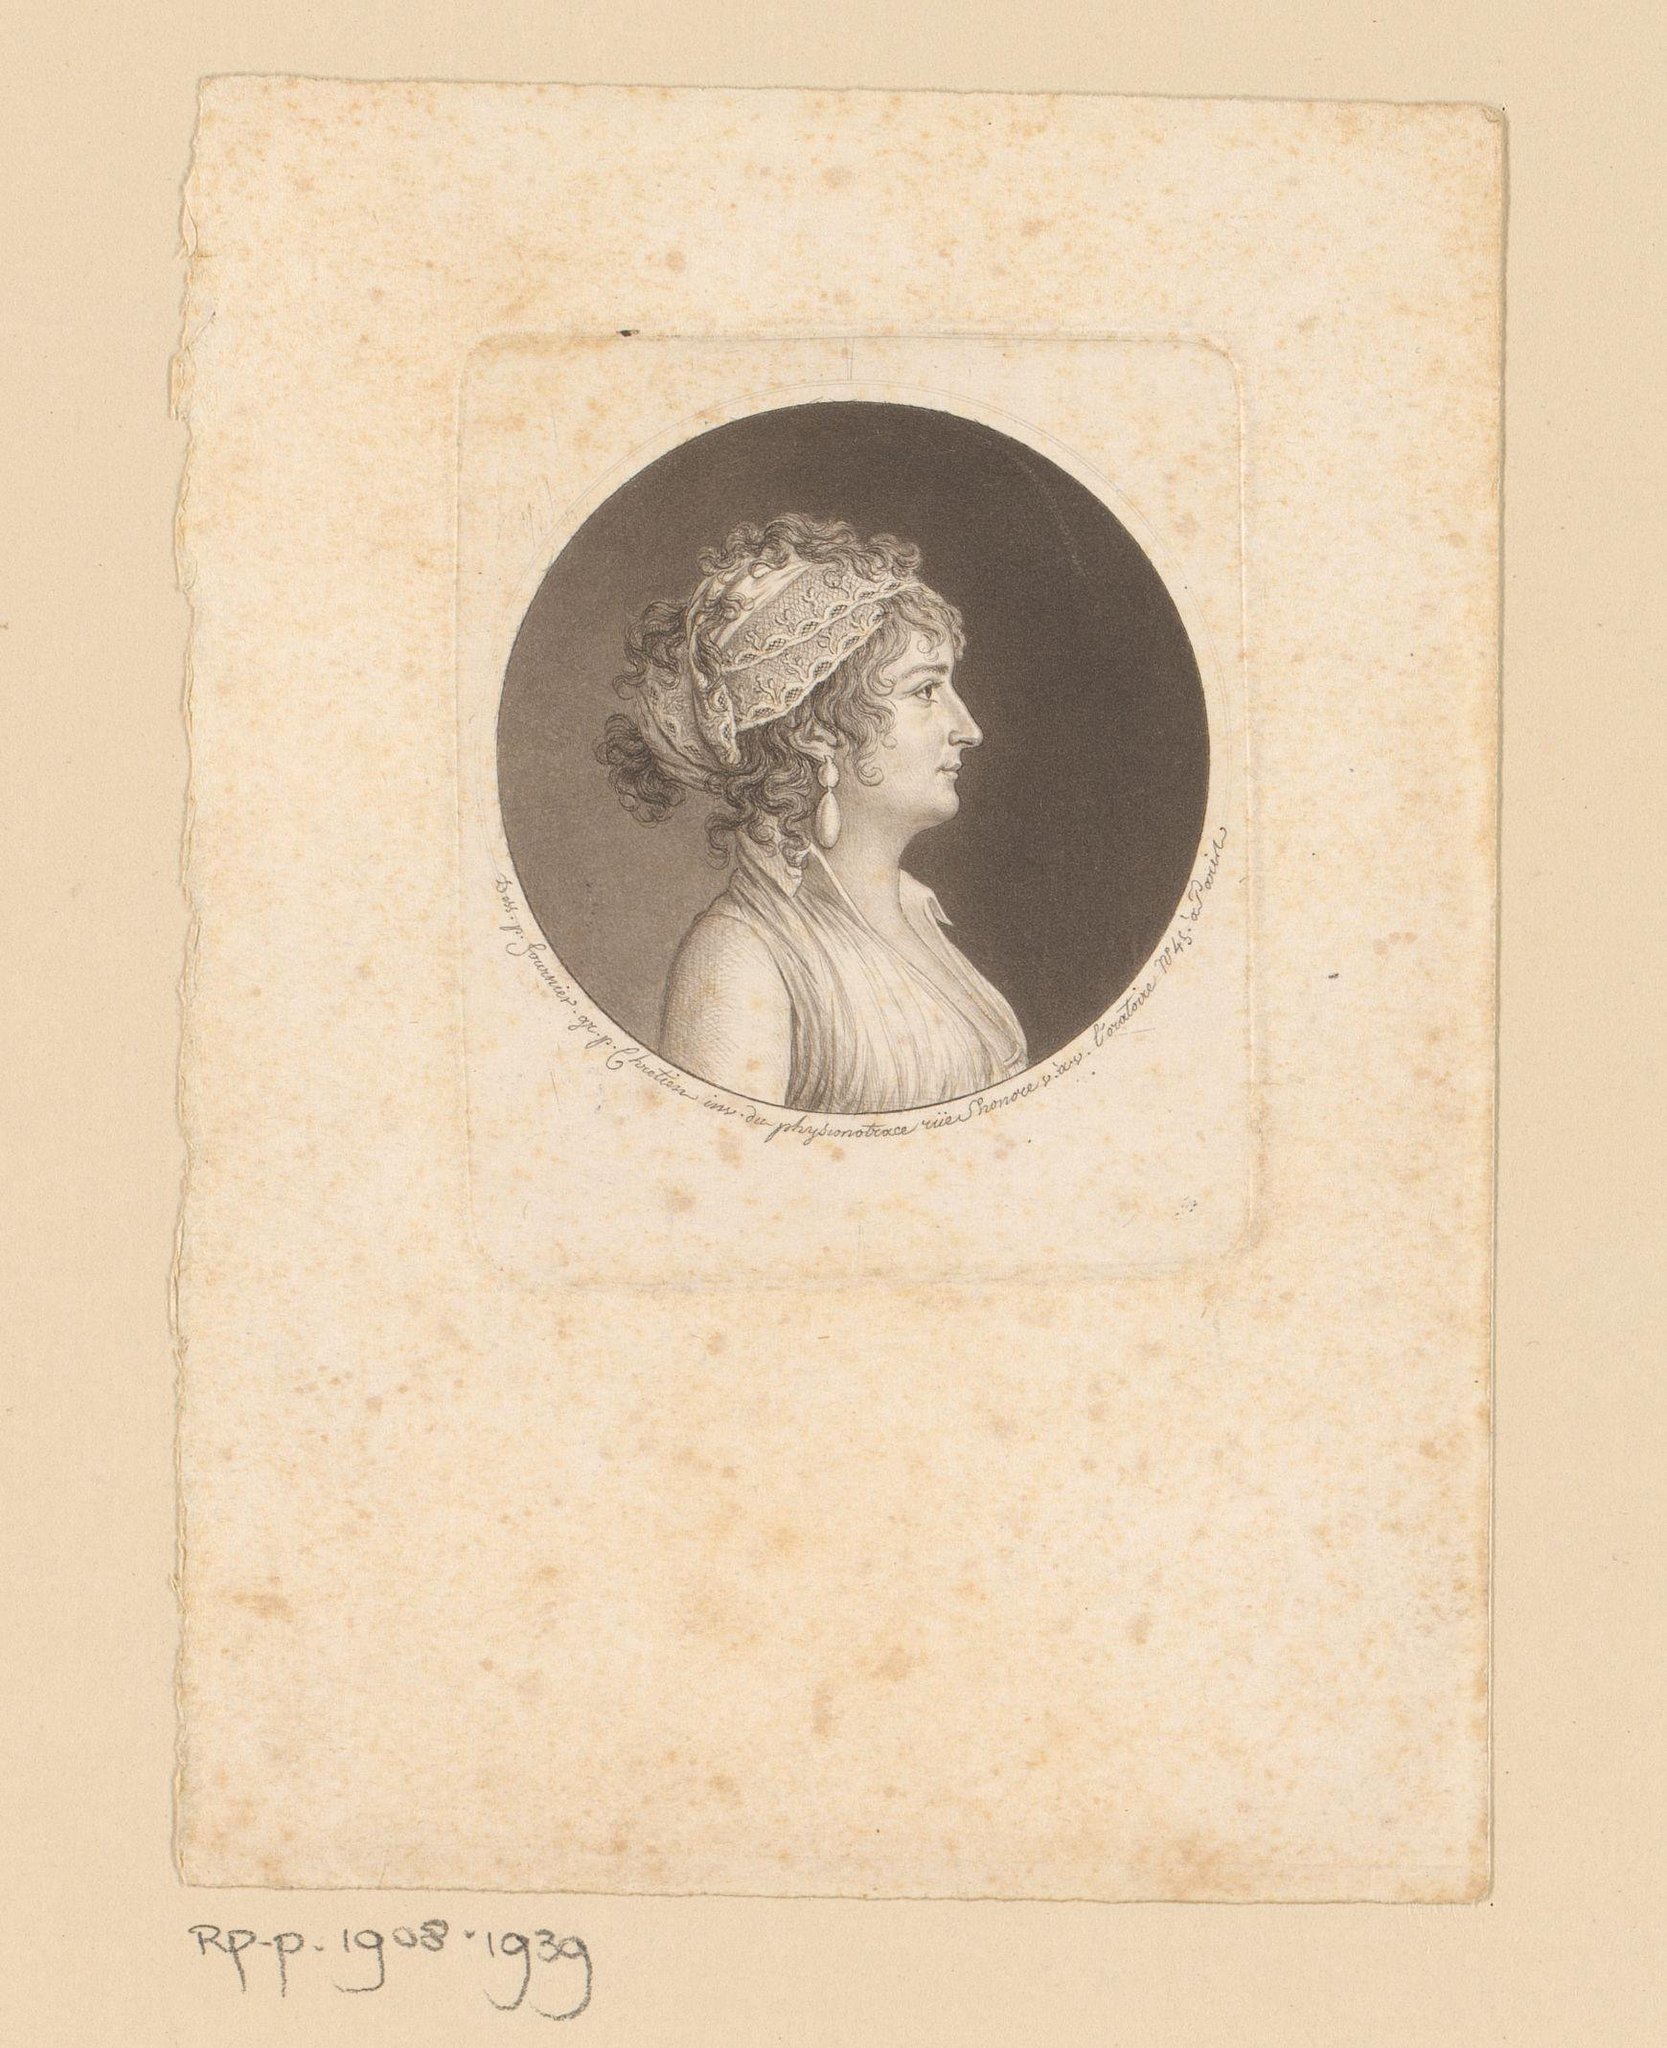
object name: physionotrace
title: Portret van een onbekende vrouw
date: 1785-1811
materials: paper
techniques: aquatint, etching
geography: paris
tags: silhouette-apparatus, 'physionotrace', anonymous historical person portrayed alone - bb - woman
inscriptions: collector's mark: Lugt 2228